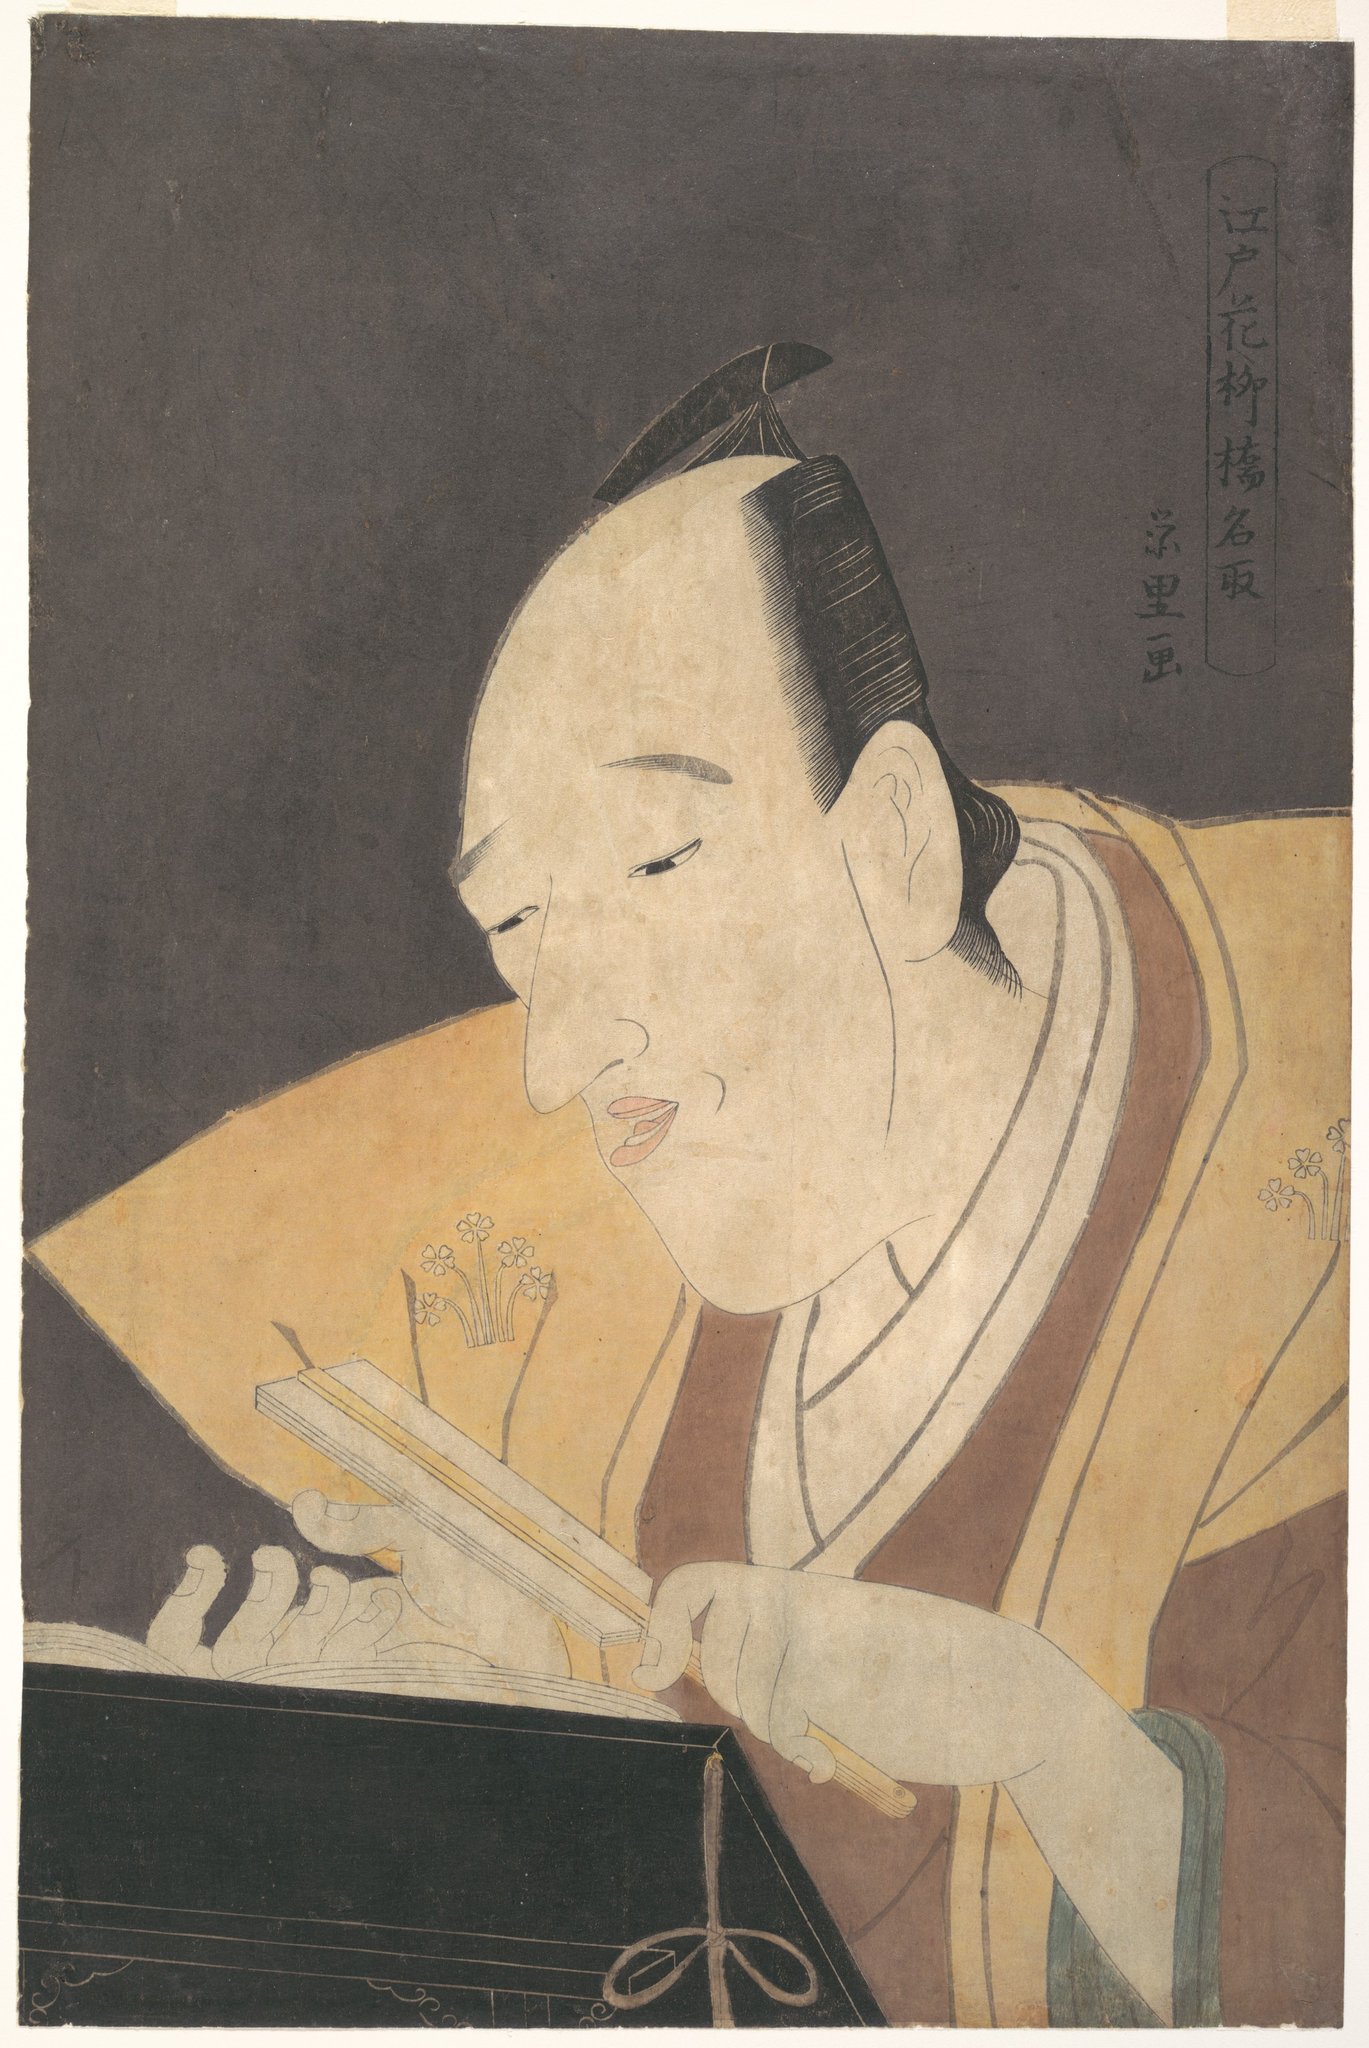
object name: print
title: The Jo-ruri Narrator Tomimoto Buzendaya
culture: japanese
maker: chōkyōsai eiri 鳥橋斎栄里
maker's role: artist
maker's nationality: japanese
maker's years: 1789-1801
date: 1795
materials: ink, paper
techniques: woodblock print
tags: men,reading